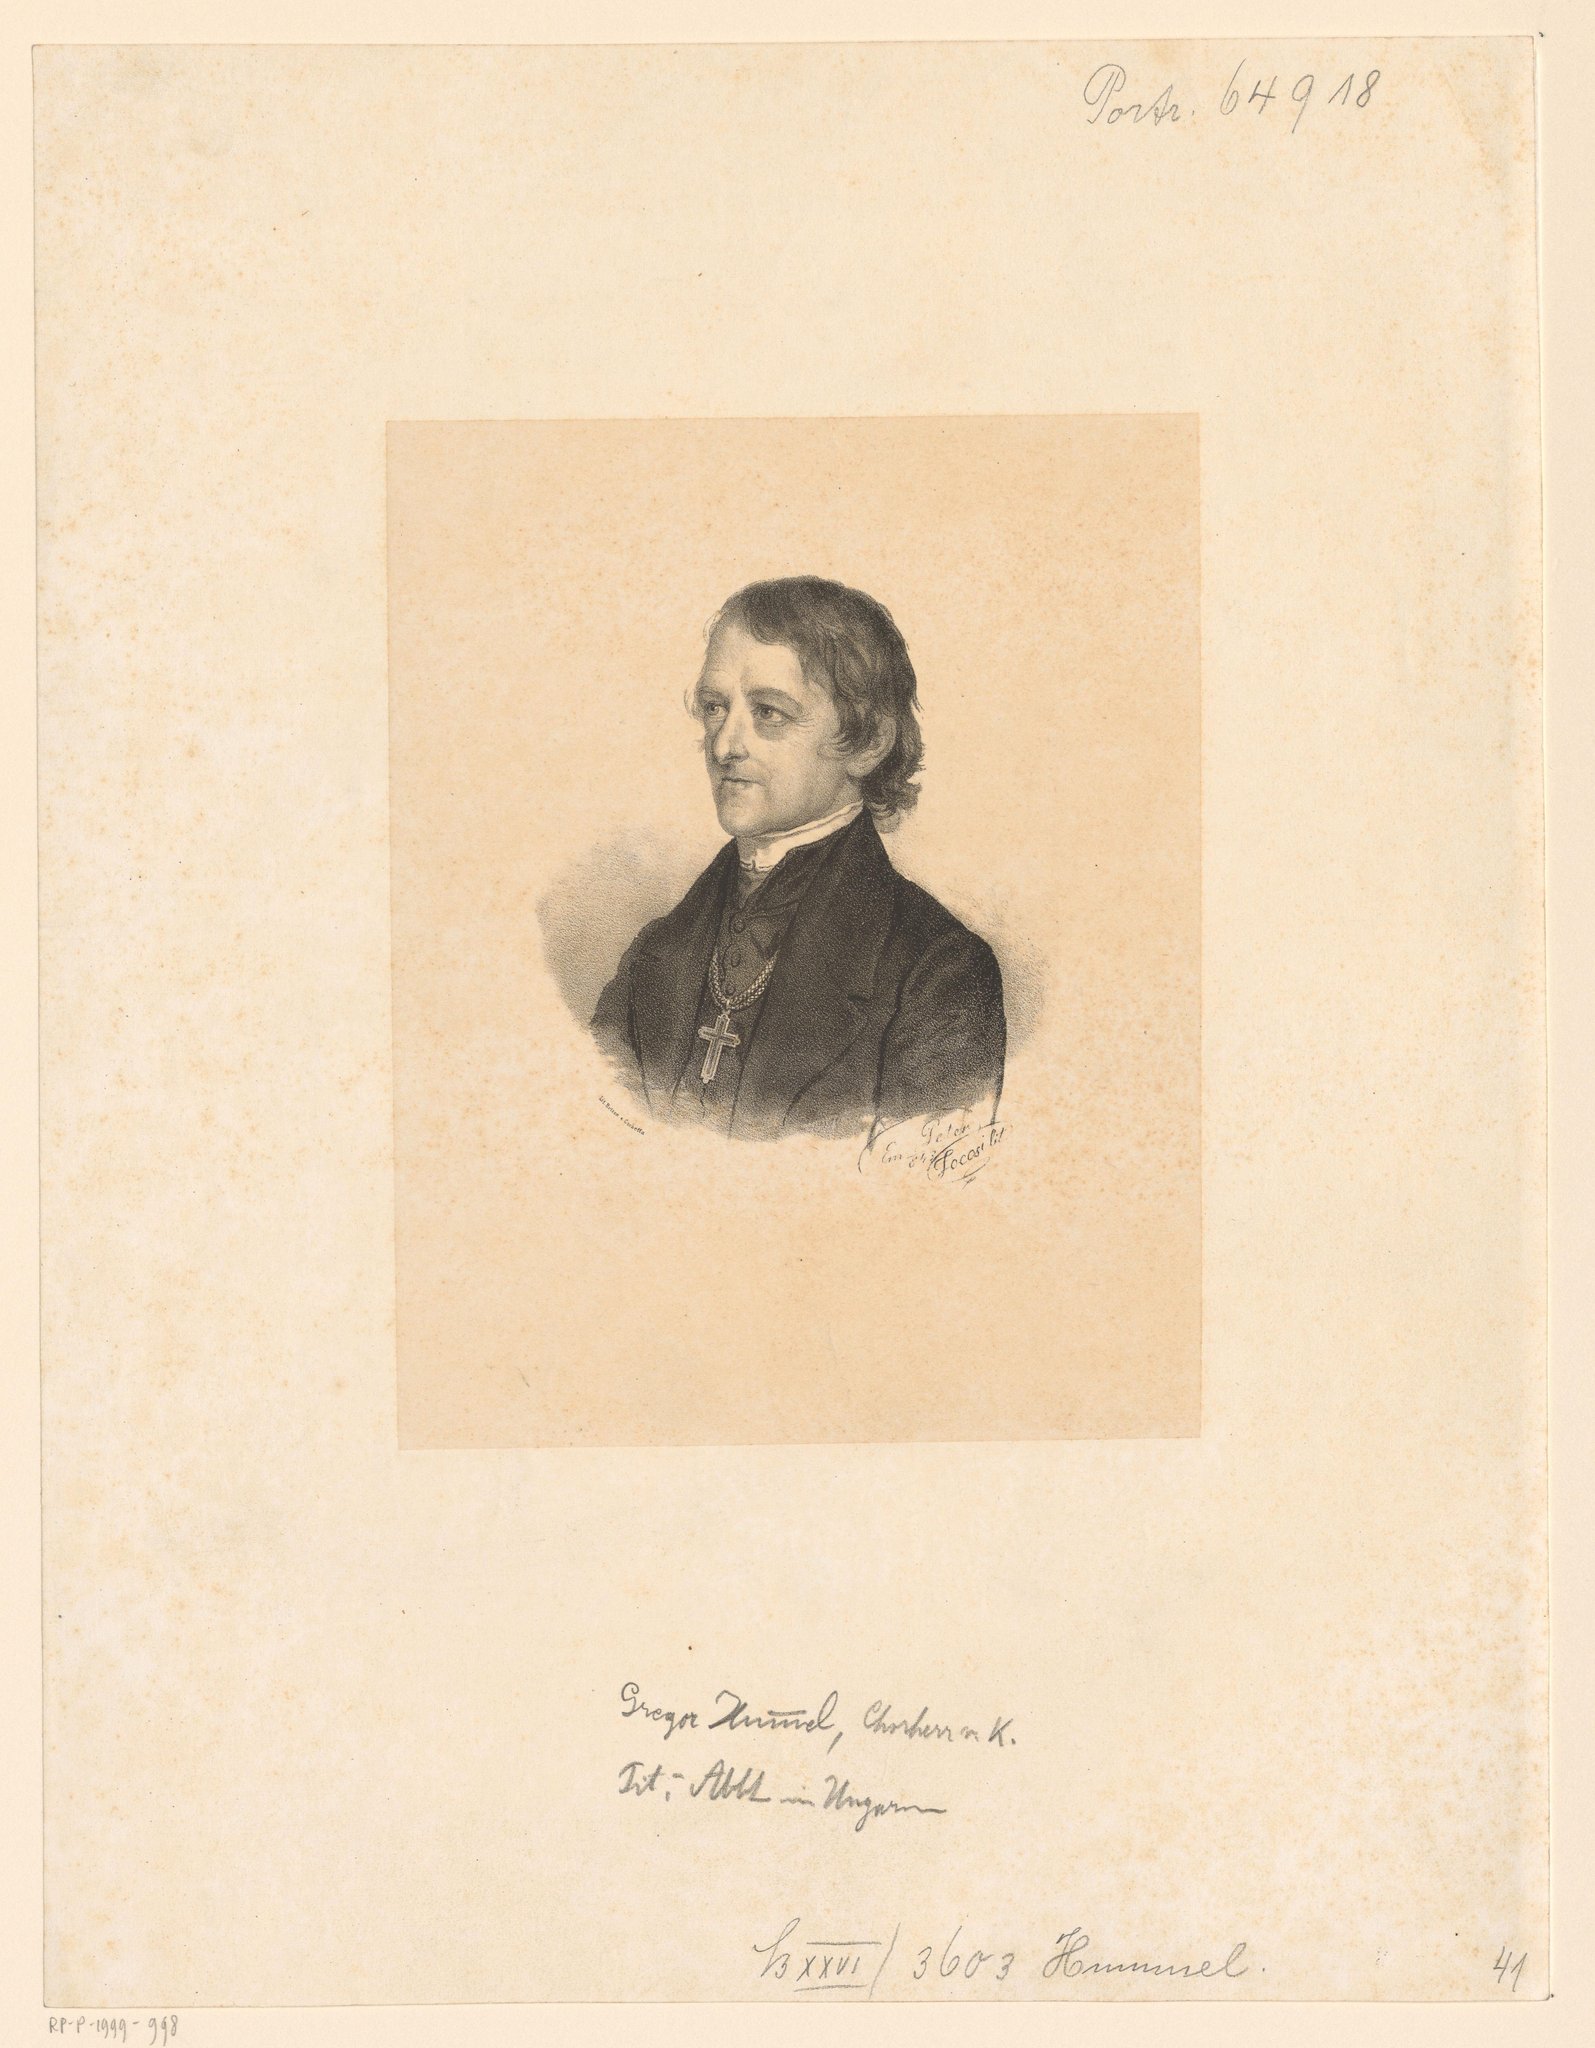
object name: print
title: Portret van Gregor Hummel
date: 1843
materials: paper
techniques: lithograph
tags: historical persons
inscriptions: collector's mark: Lugt 2228, collector's mark: Lugt 2760